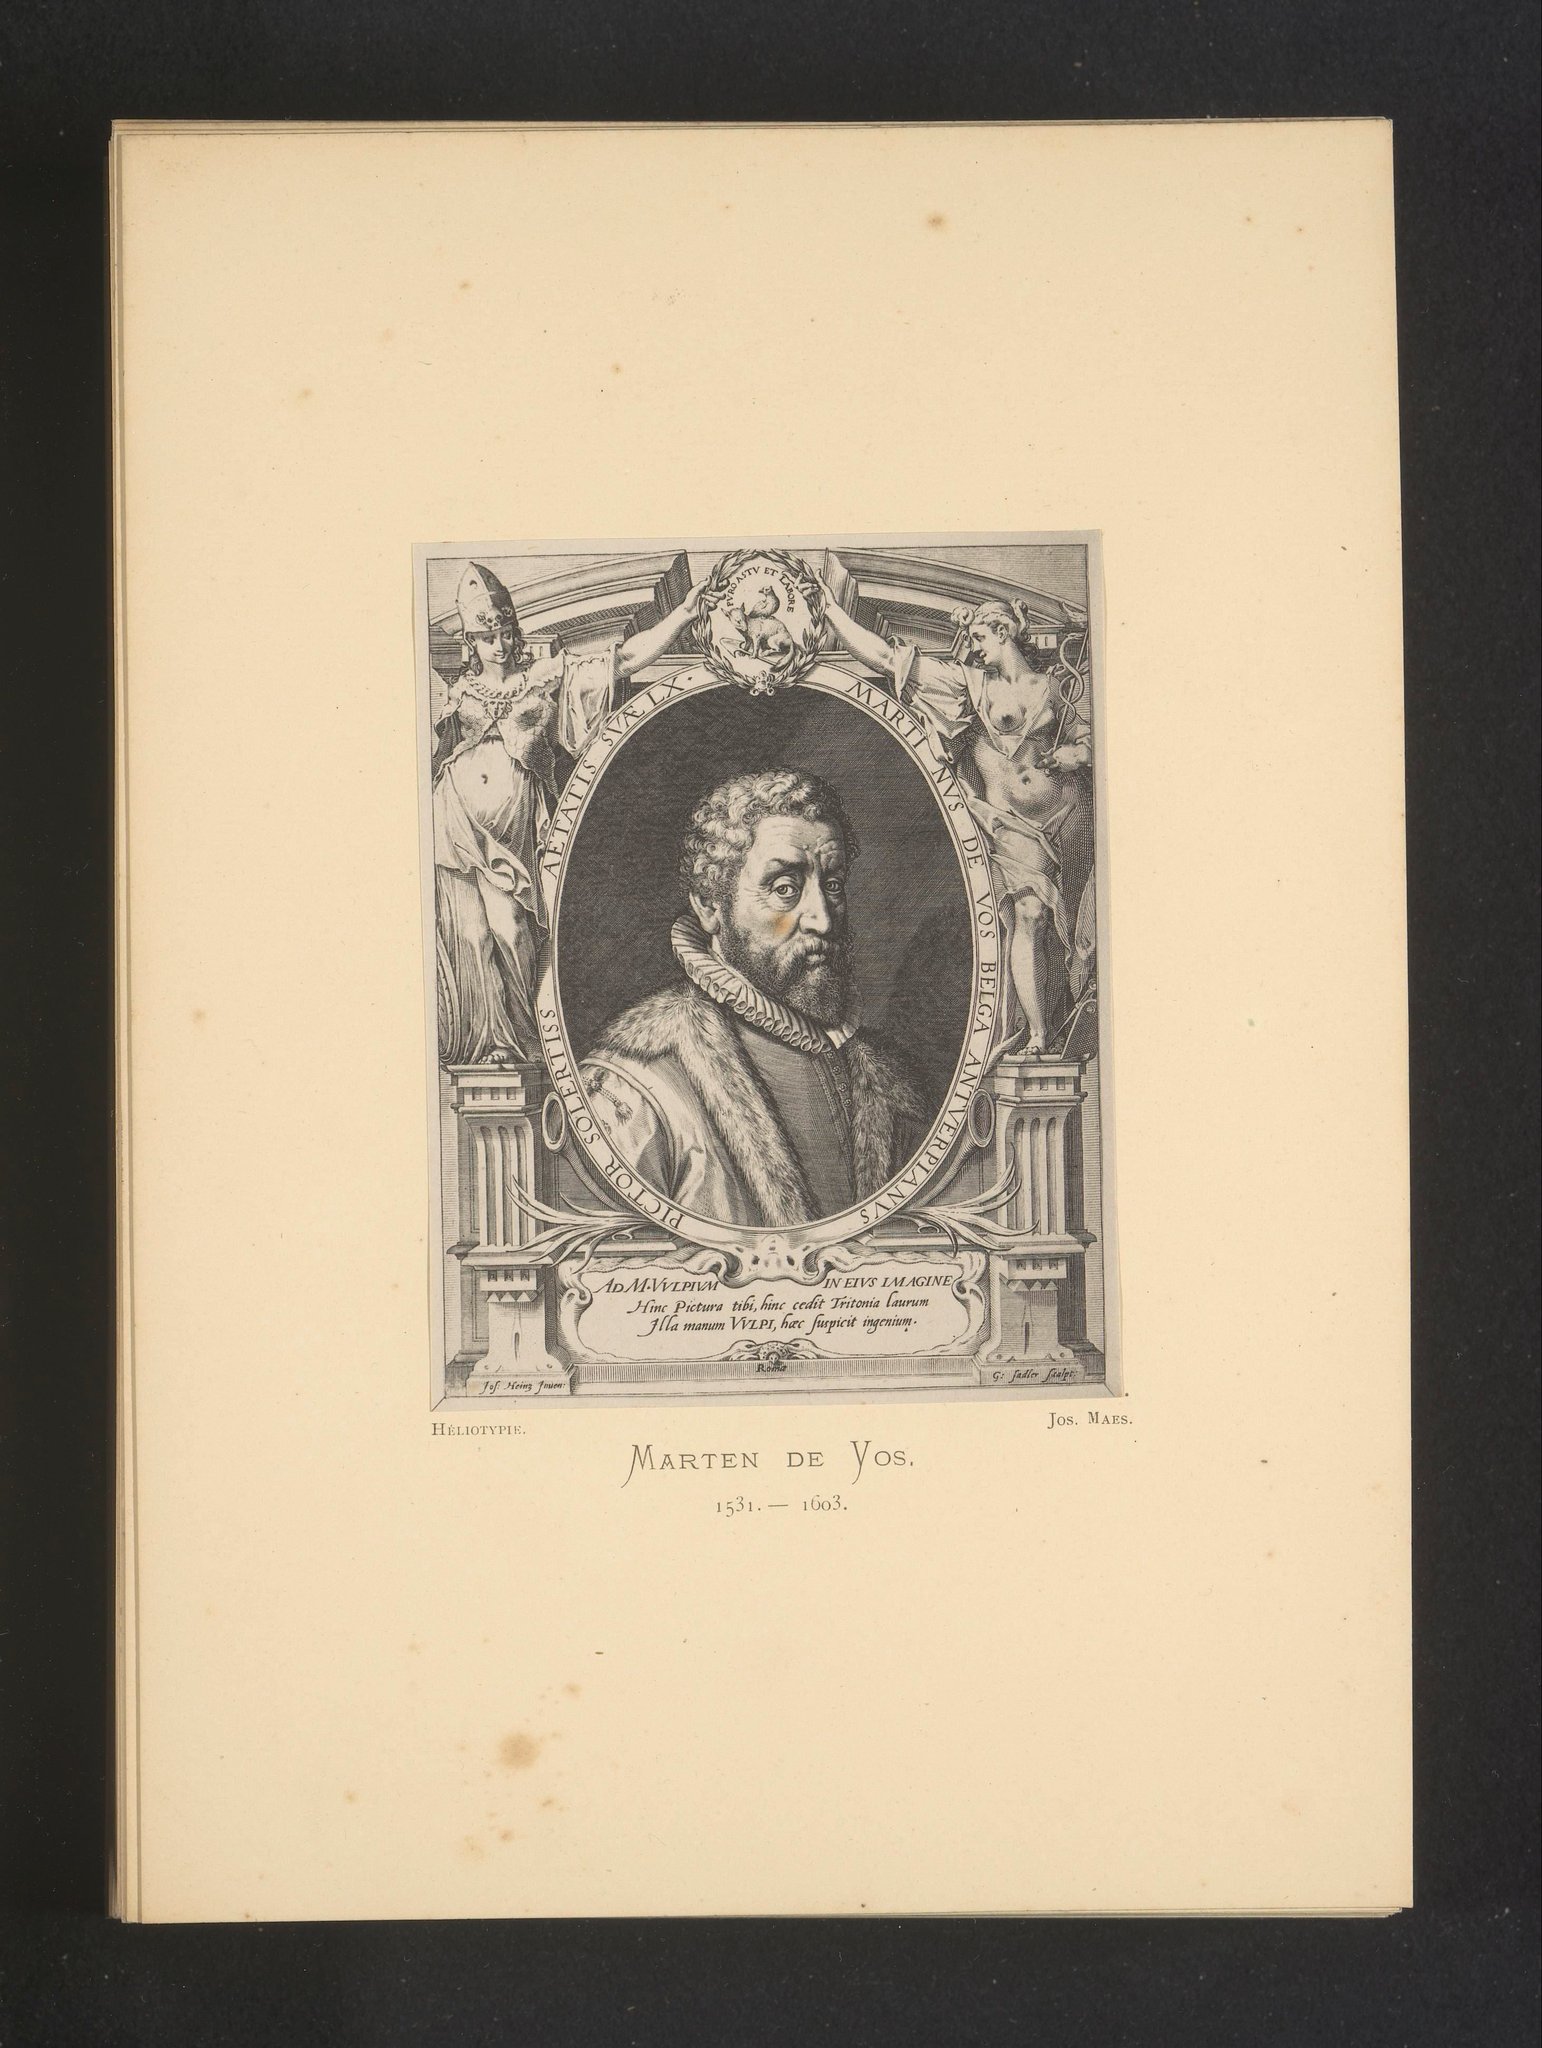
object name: reproduction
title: Marten de Vos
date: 1872-1877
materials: cardboard, paper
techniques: photograph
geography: antwerp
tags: antwerp, painter, draughtsman, maerten de vos, historical persons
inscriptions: inscription: ‘1531. - 1603.’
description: Deze prent maakt deel uit van een omslag met 150 prenten en een katern met een lijst van afbeeldingen.